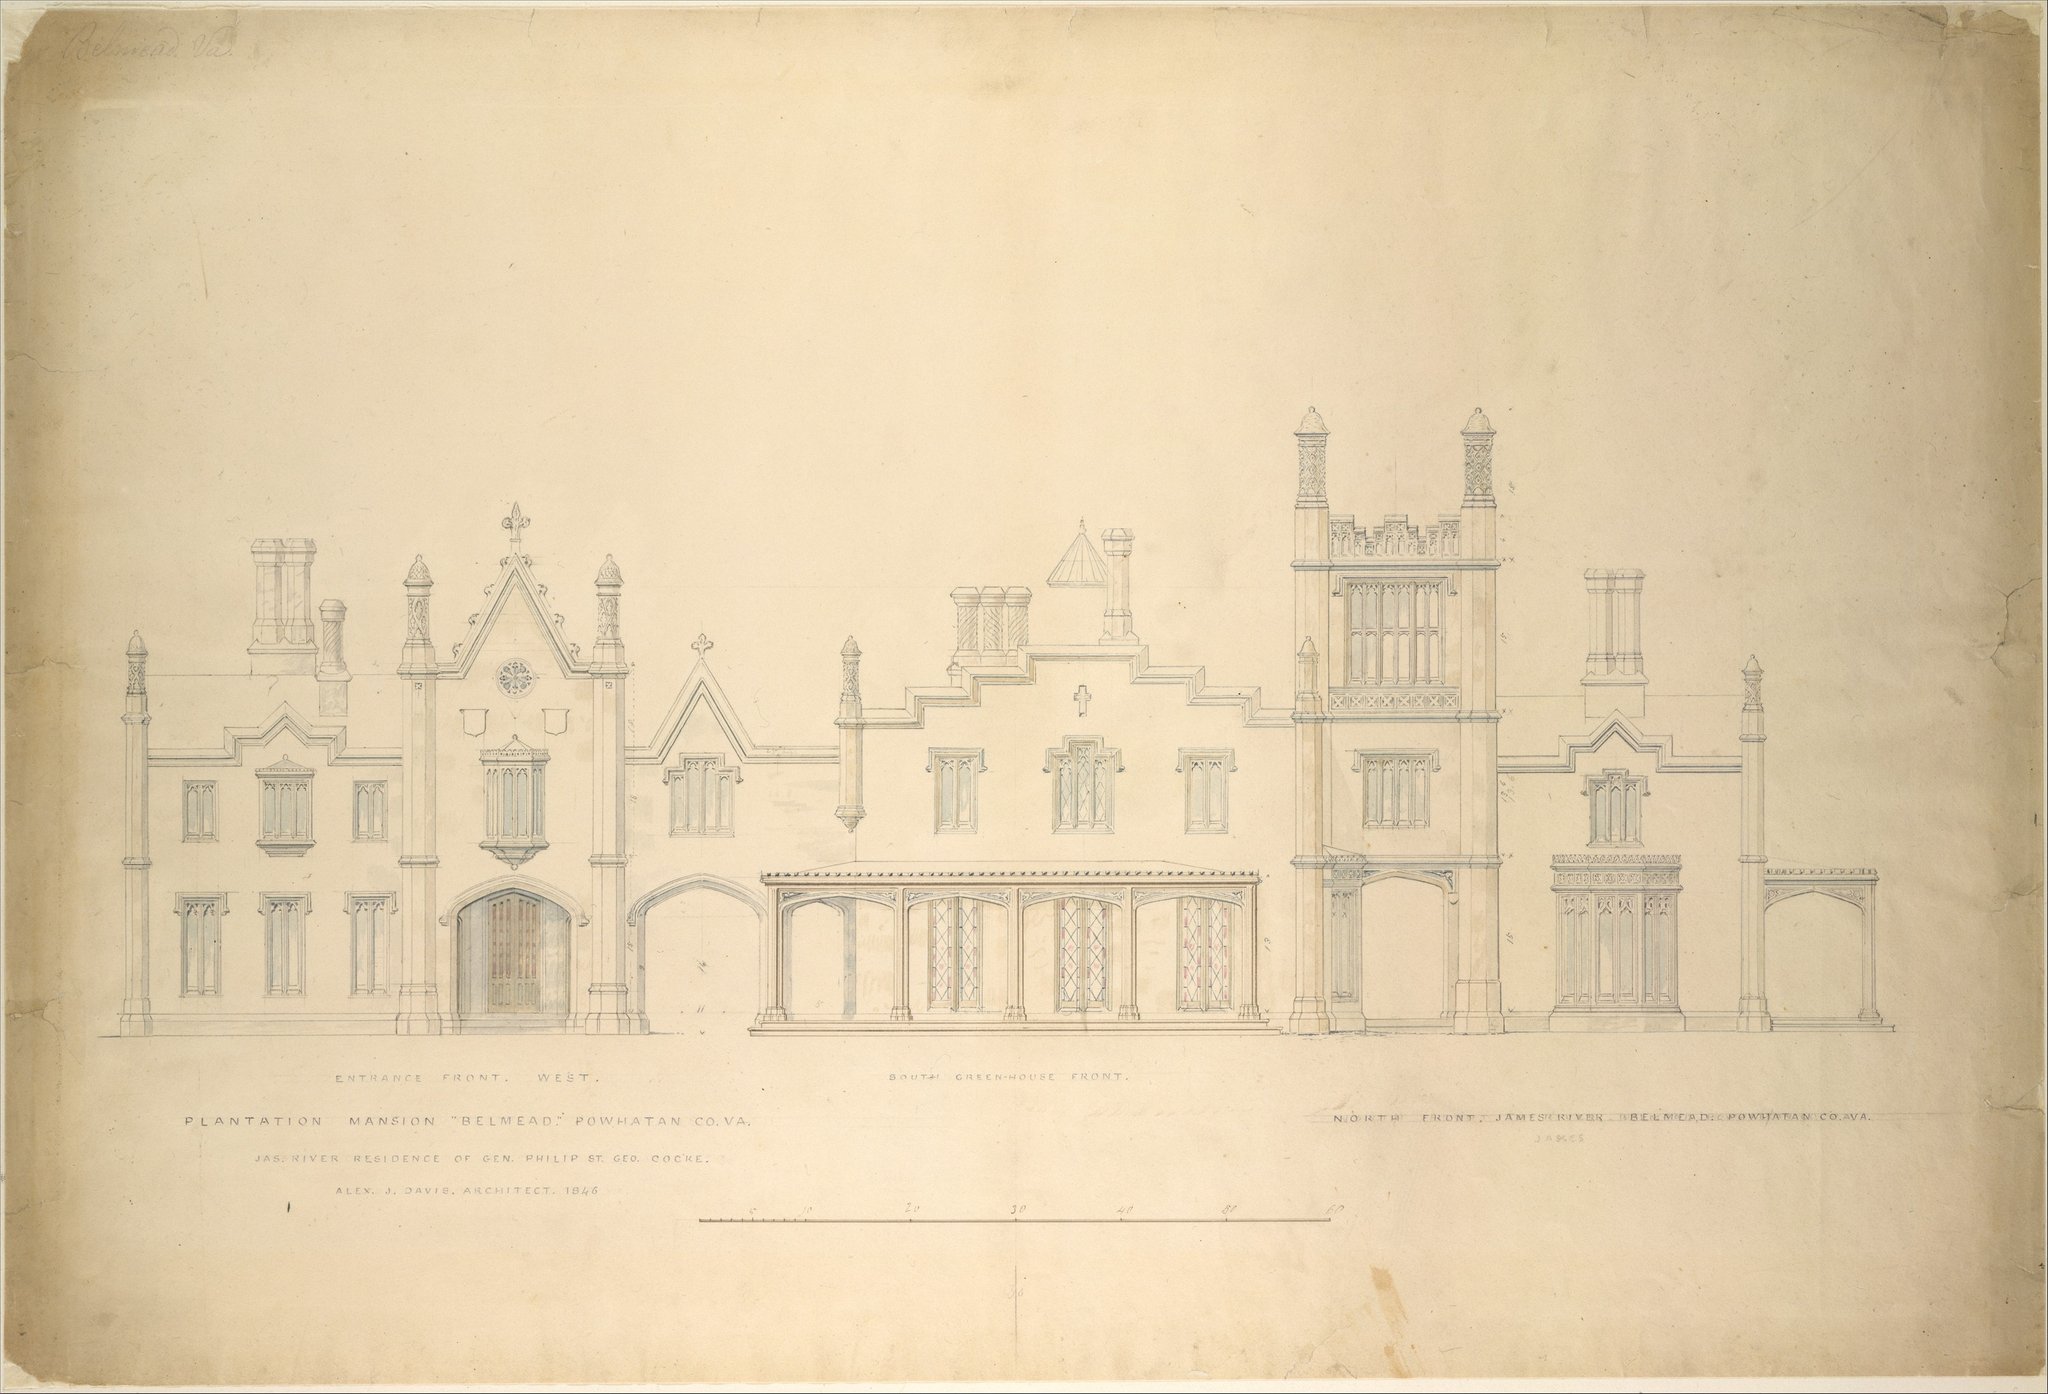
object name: drawing ornament architecture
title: Belmead, Plantation Mansion for Philip St. George Cocke, Powhatan Co., Virginia (partial elevations of entrance facade, greenhouse facade and James River facade, shown as continuous)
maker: alexander jackson davis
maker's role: artist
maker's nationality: american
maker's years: 1803-1892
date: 1846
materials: ink, paper, watercolor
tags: architecture,houses